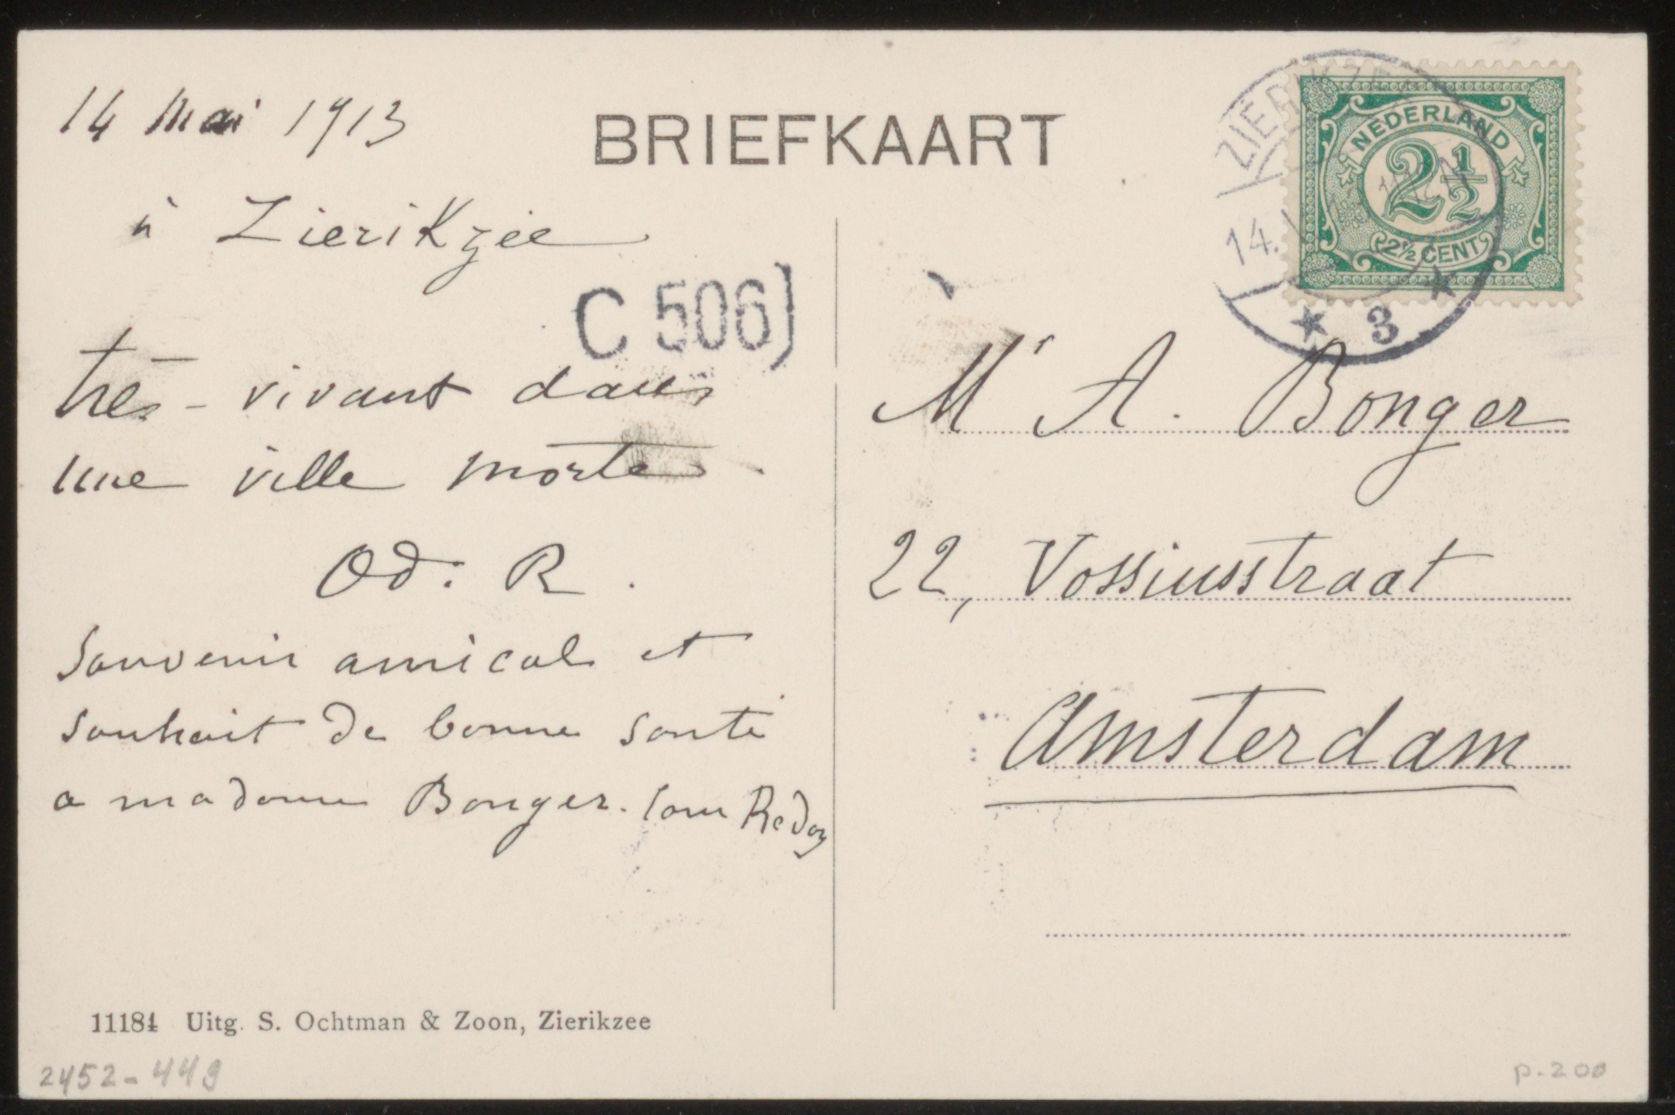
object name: ansichtkaart, prentbriefkaart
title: Prentbriefkaart aan Andries Bonger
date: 1913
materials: cardboard, ink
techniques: photograph, pen, writing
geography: zierikzee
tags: amsterdam, andries bonger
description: Prentbriefkaart behoort tot een album samengesteld door weduwe Françoise W.M. Barones van der Borch van Verwolde met afschriften van brieven met betrekking tot (de familie van) Odilon Redon. De prentbriefkaart werd bewaard op pagina 200.